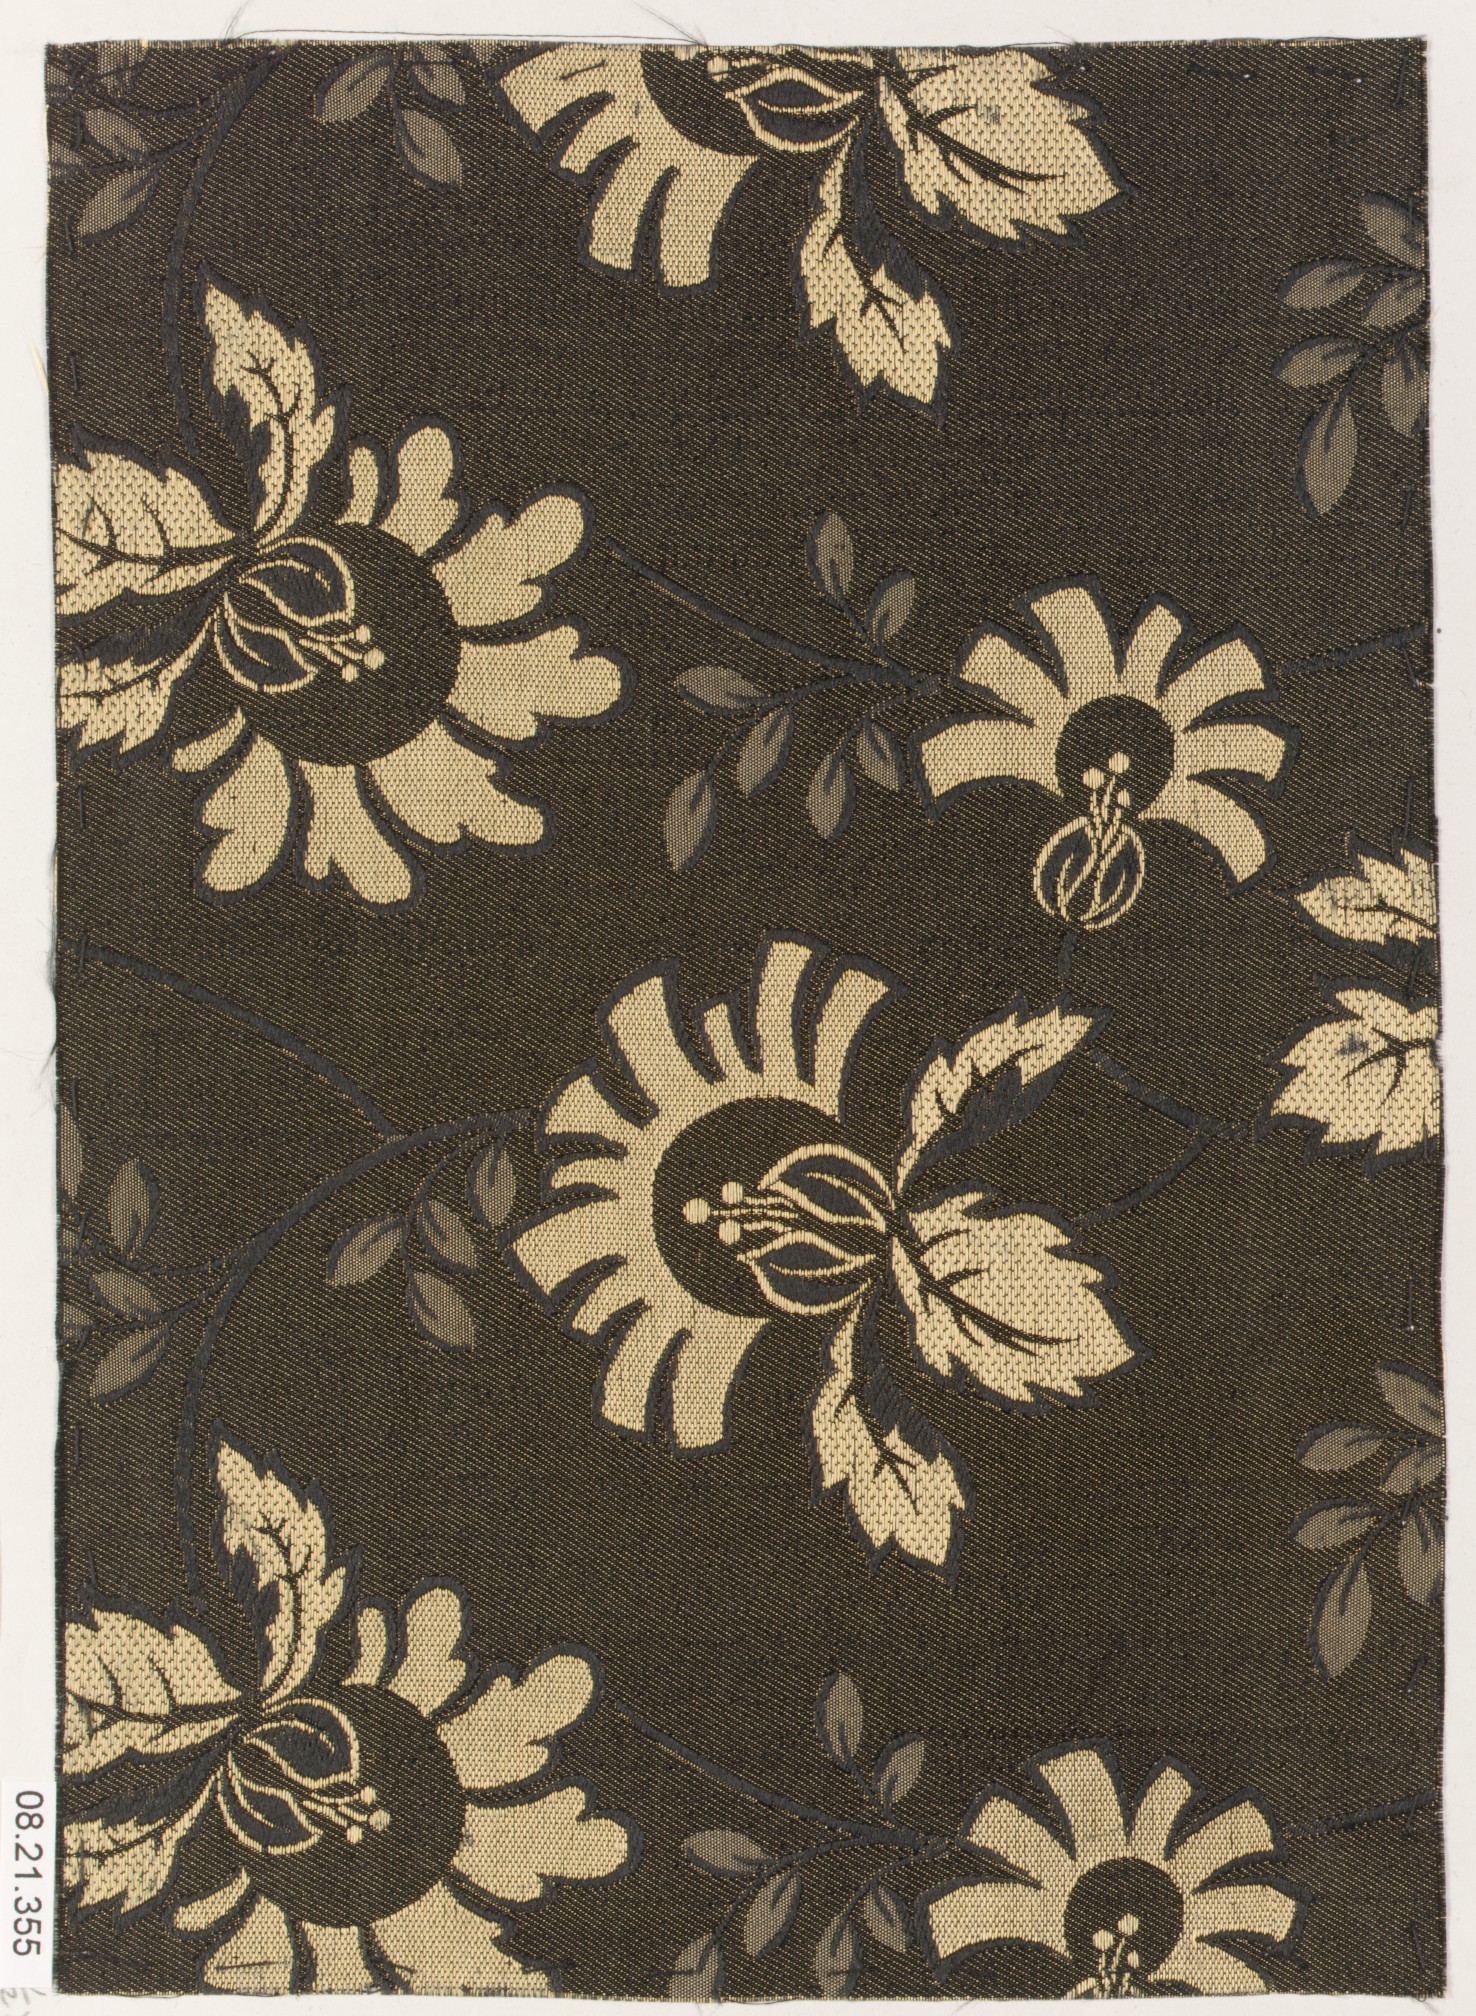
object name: textile sample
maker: Anonymous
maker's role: designer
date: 1900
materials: silk